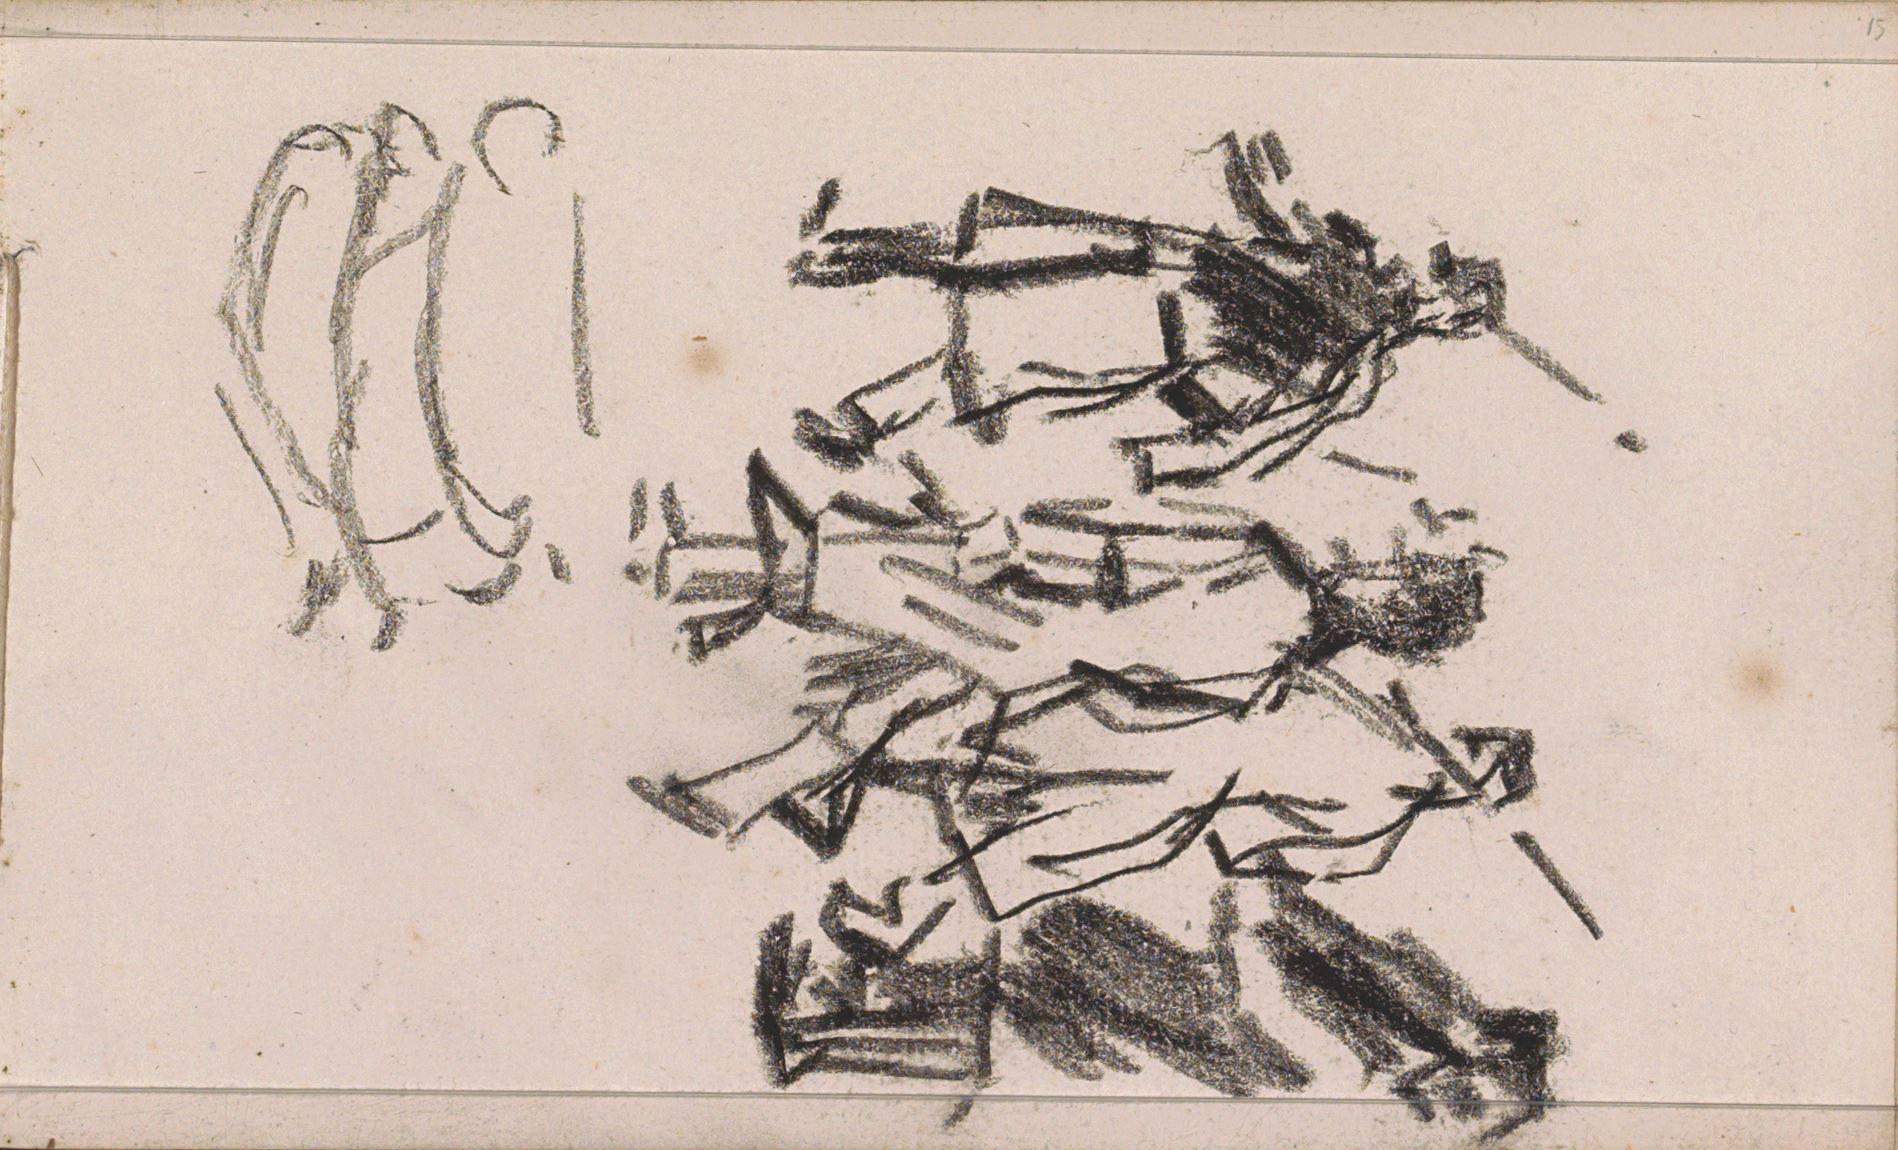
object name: sketchbook leaf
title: Groep soldaten met geweren, mogelijk huzaren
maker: isaac israels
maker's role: draughtsman, painter, print maker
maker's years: 1865-1934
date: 1875-1934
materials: chalk, paper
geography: the hague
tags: firearms: rifle, the soldier; the soldier's life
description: Pagina 15 uit schetsboek XLVIII met 62 pagina's.